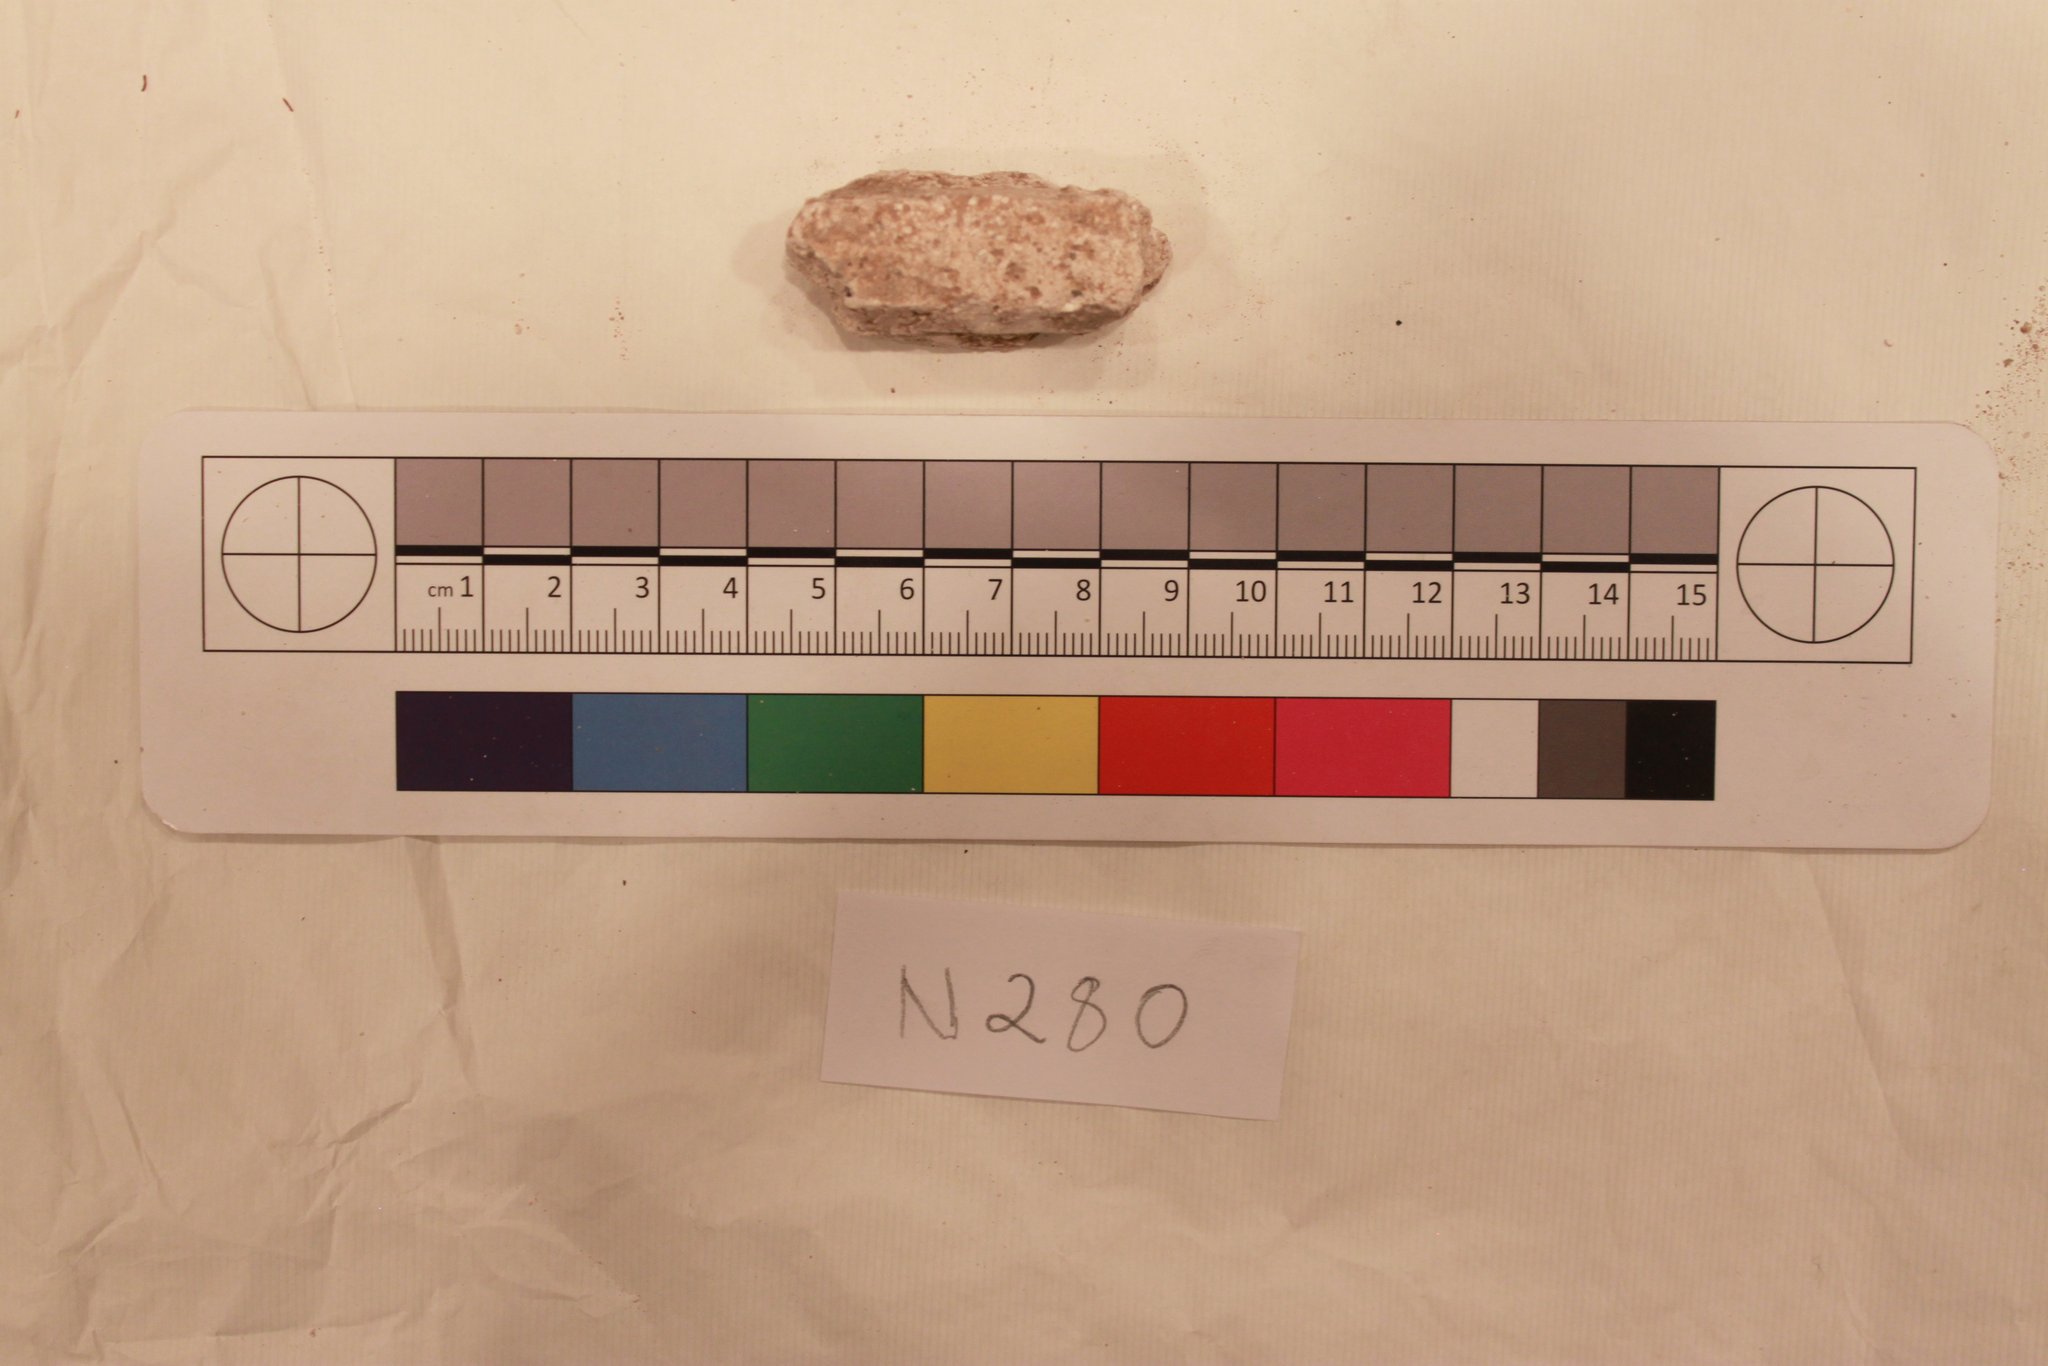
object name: fragment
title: Stucco Fragment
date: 701-1200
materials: plaster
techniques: carving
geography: iran